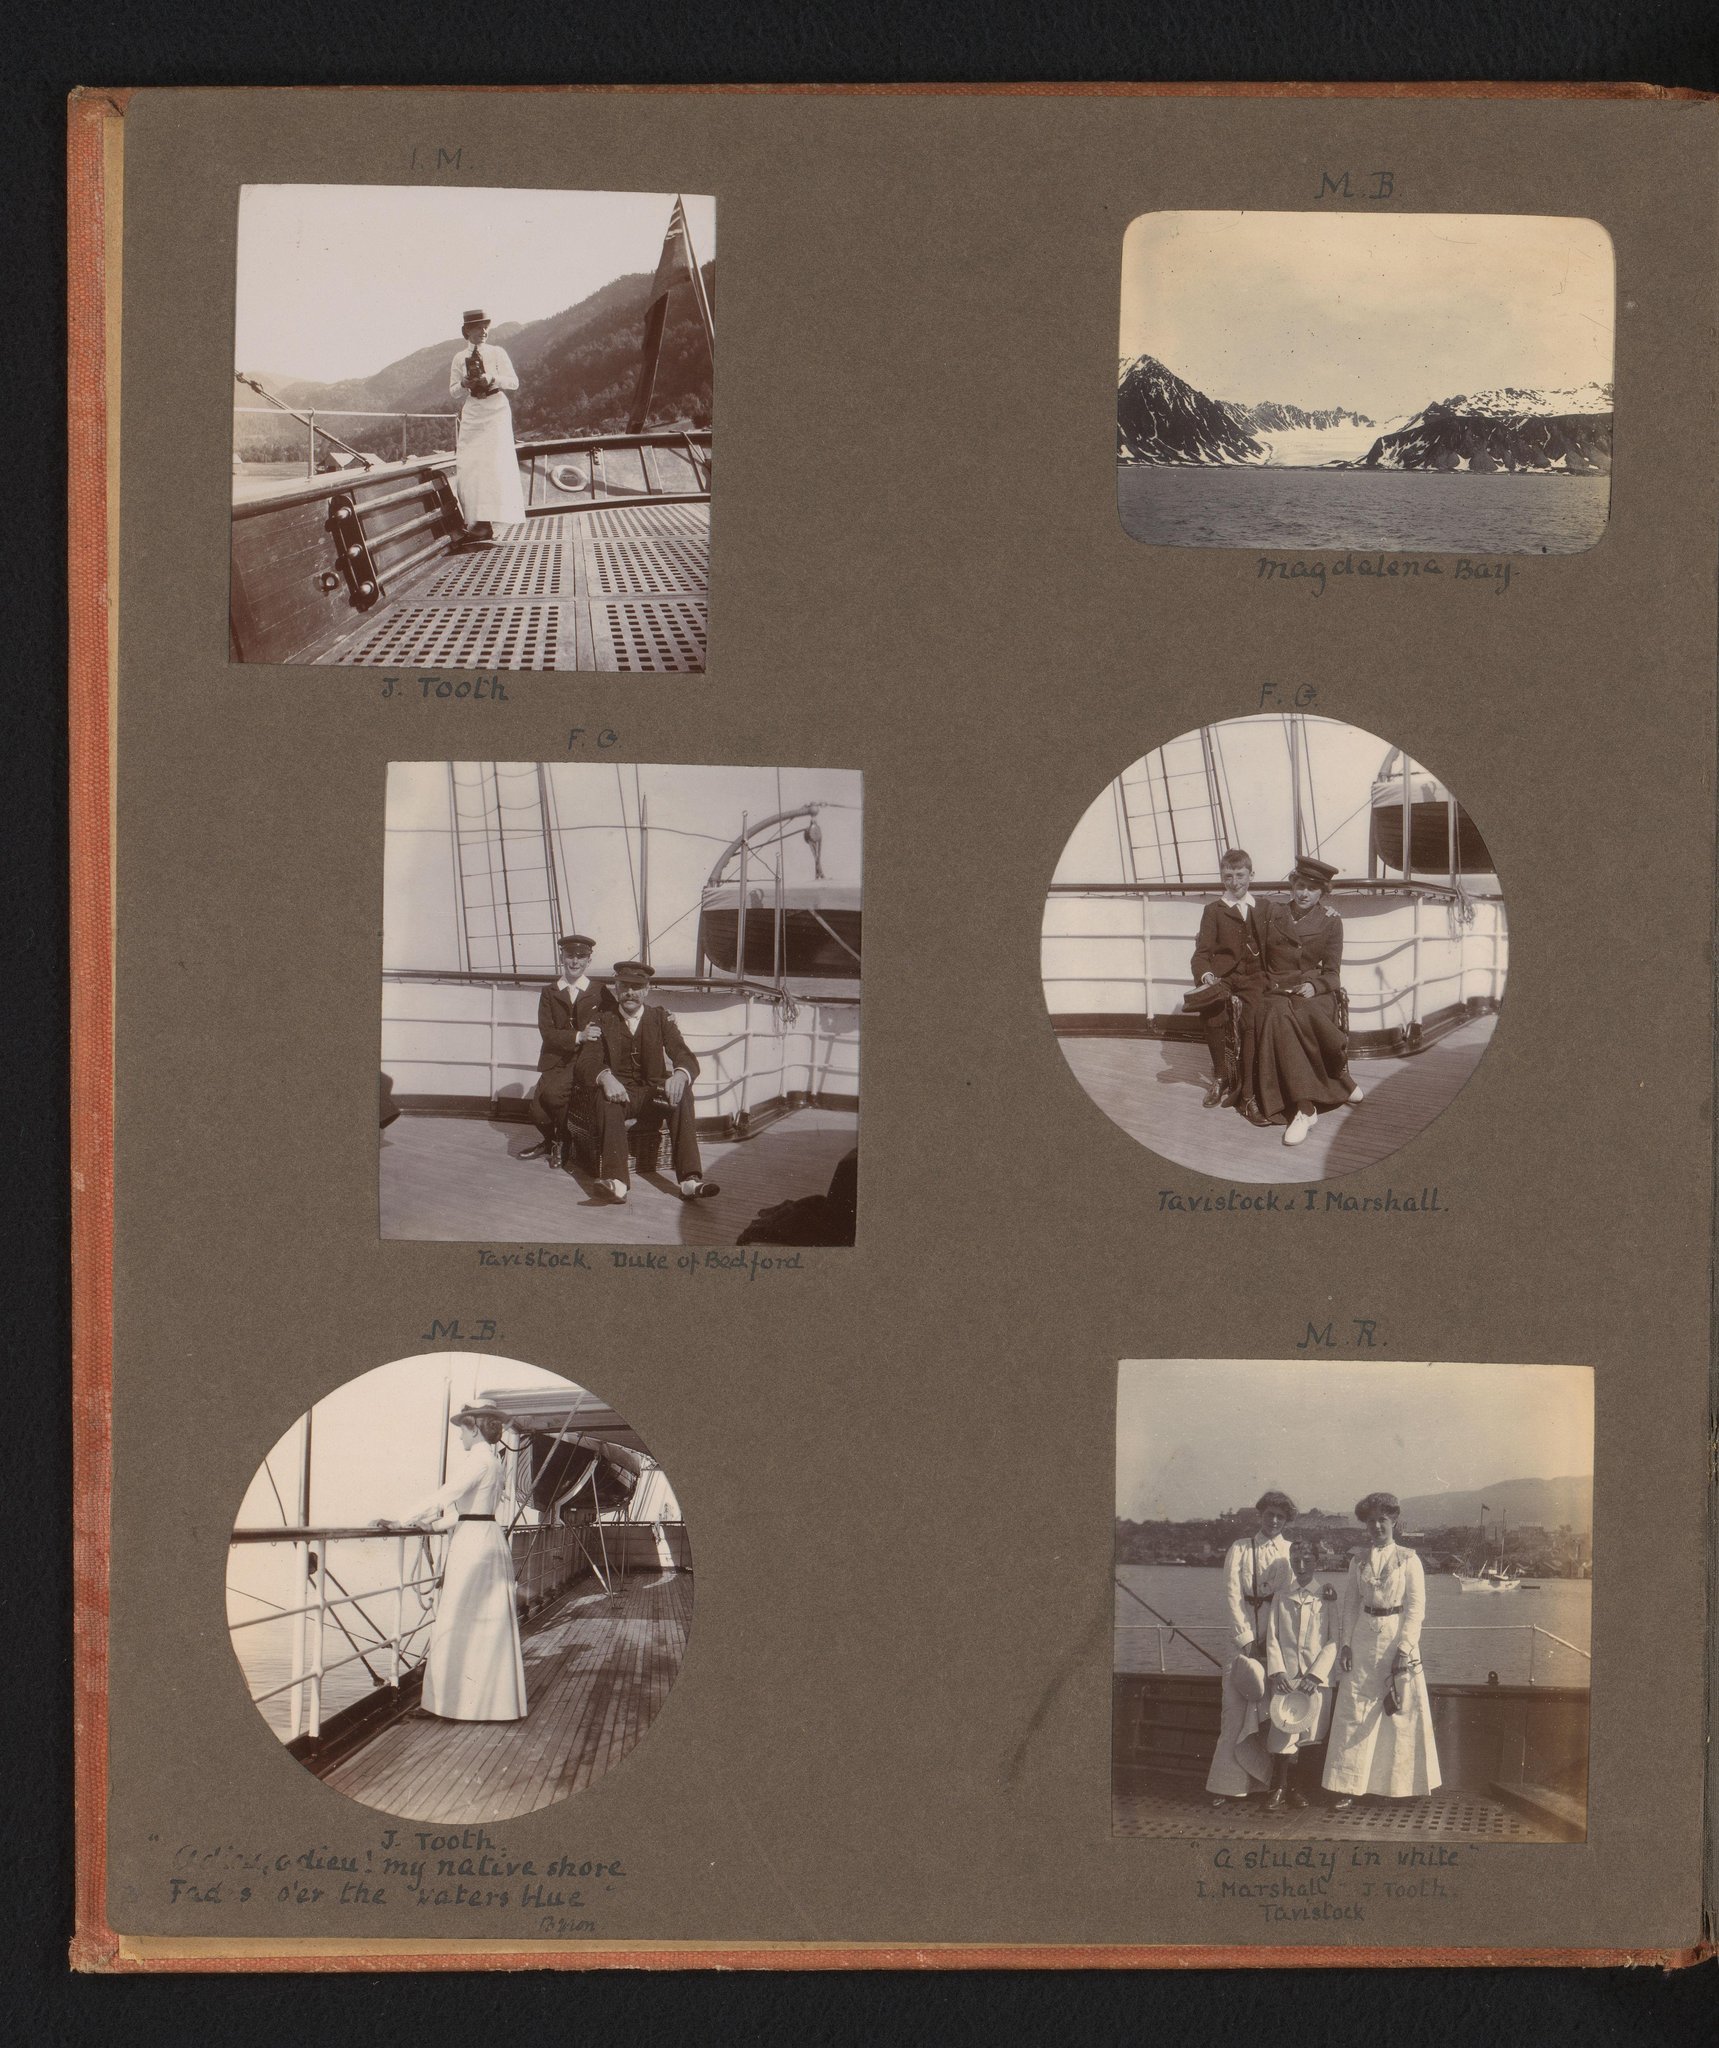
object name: album leaf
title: Zes foto's van een reis met de S.Y. Sapphire naar Spitsbergen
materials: paper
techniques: gelatin silver print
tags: j. tooth, london, mary russell, politician, gulf, bay, taking photographs - cc - out of doors, passengers ~ ship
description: Deze foto's maken deel uit van een album.